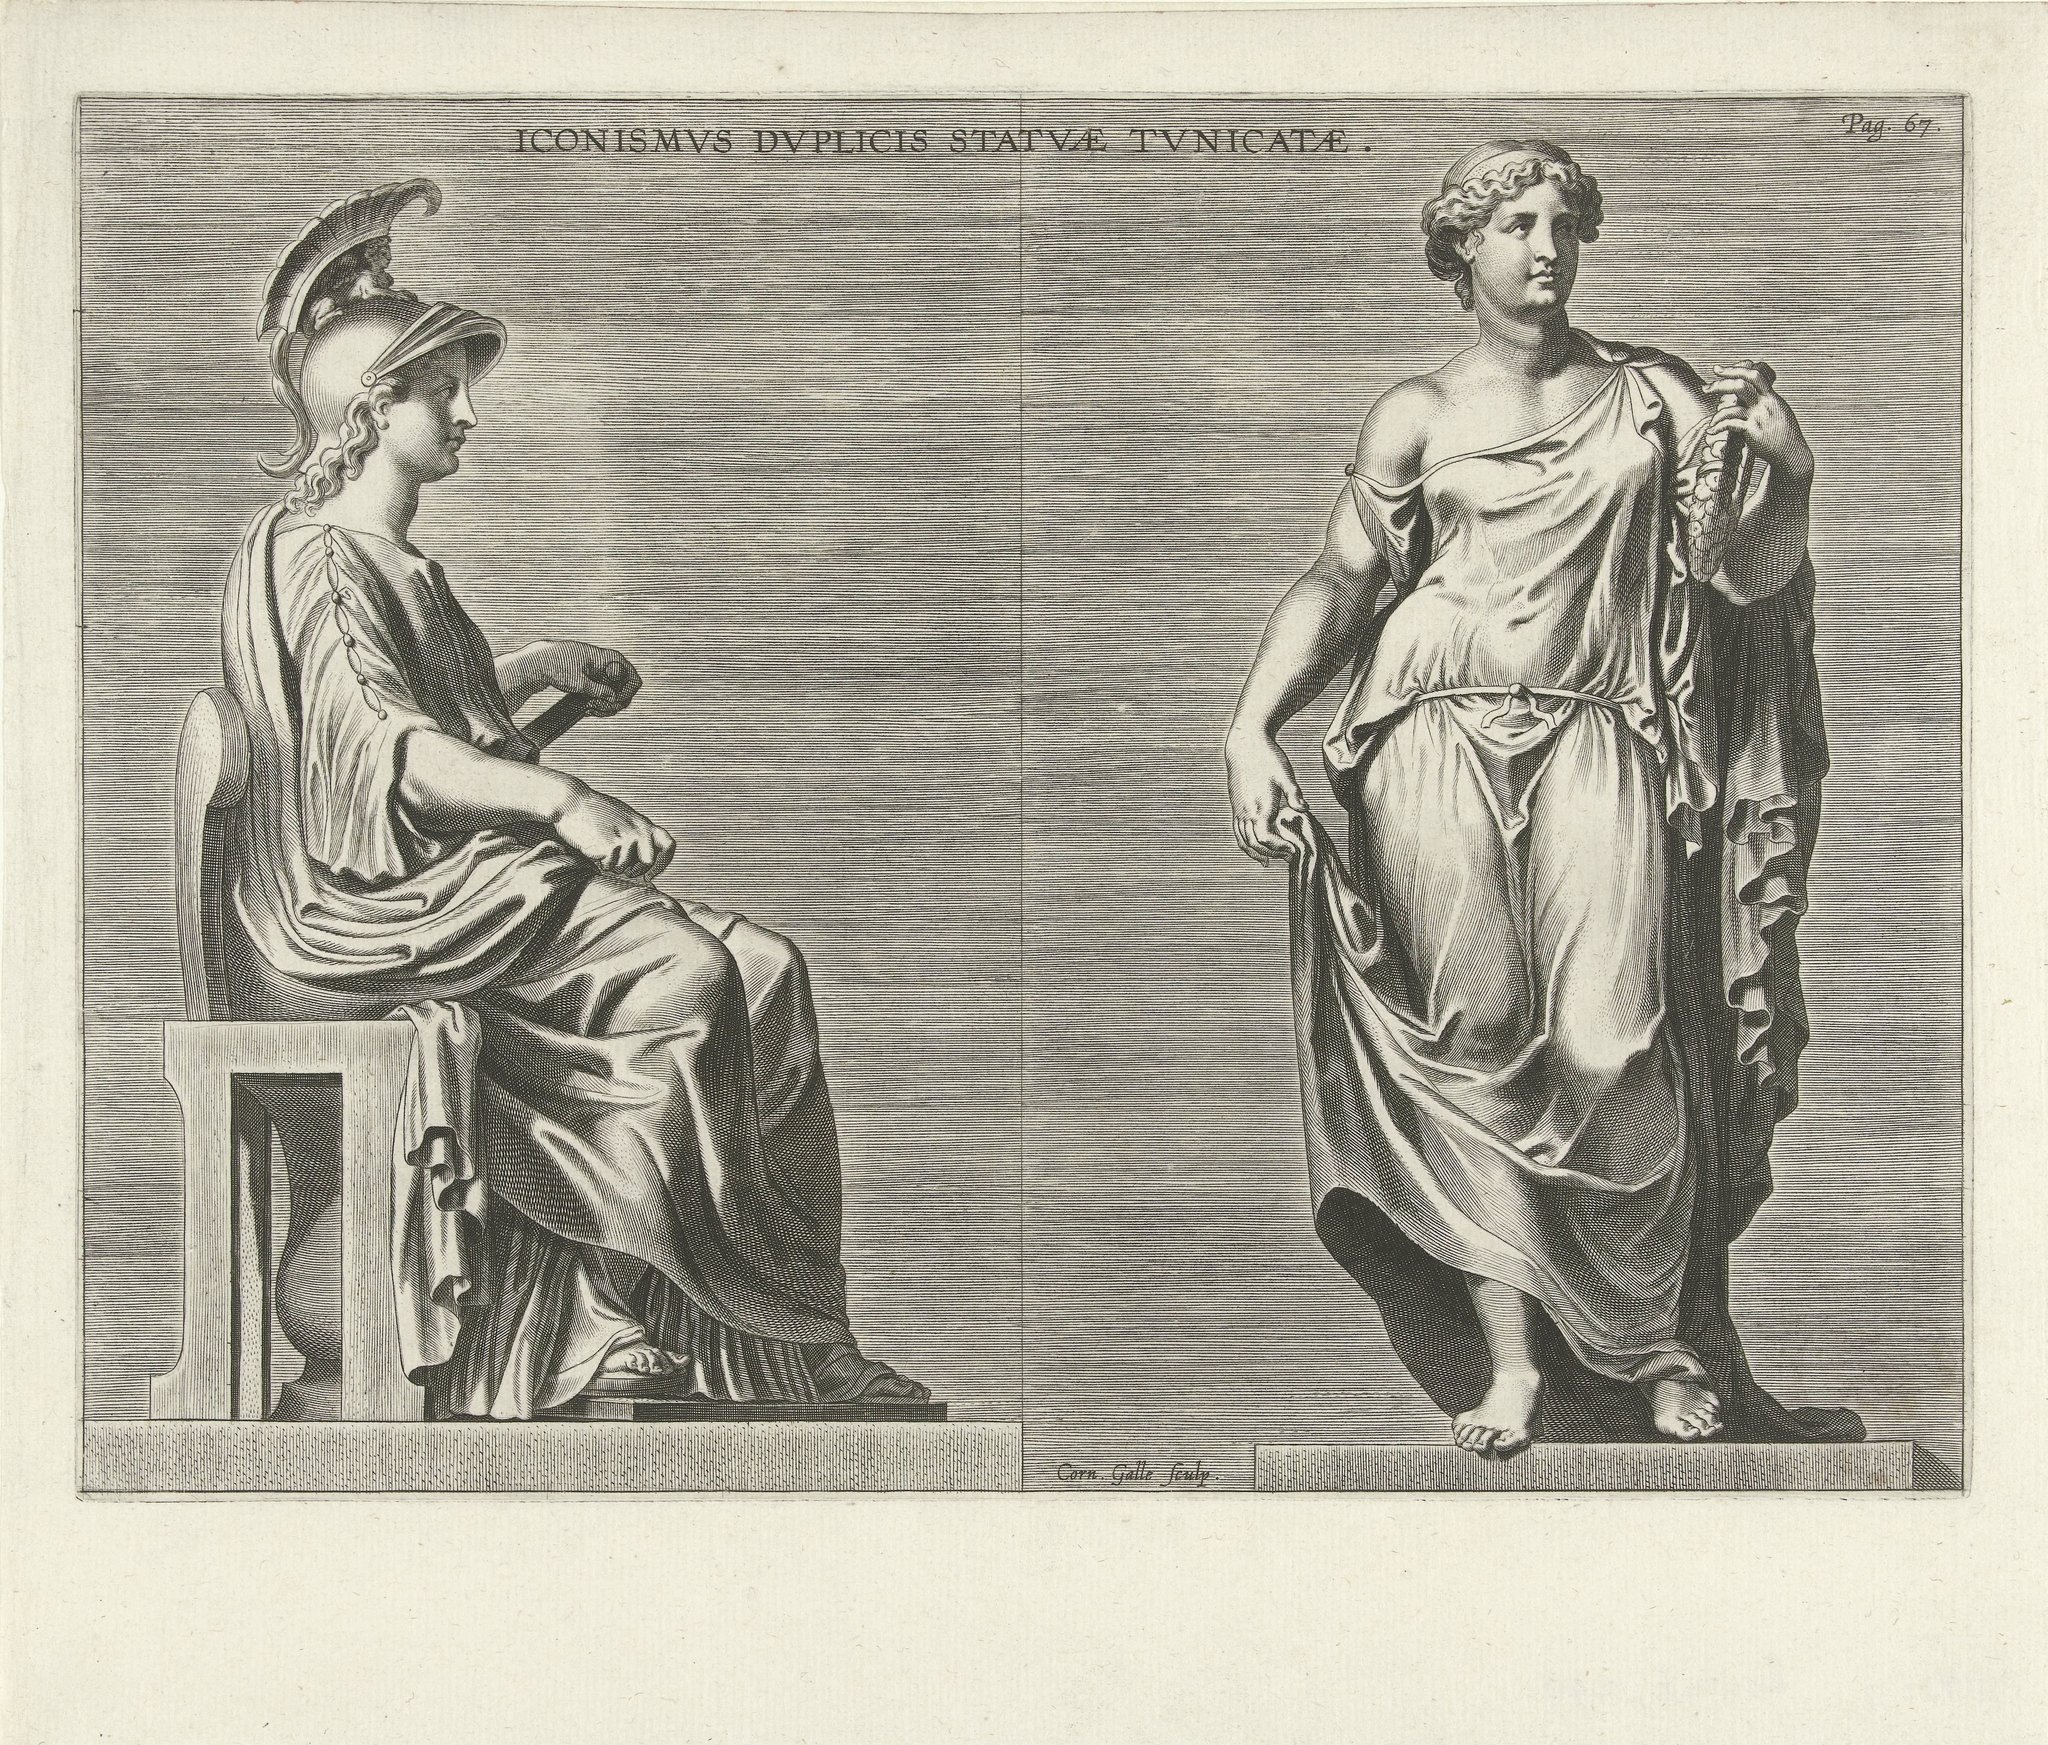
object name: book illustration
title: Iconismvs dvplicis statvae tvnicatae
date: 1608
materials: paper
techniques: engraving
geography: antwerp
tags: piece of sculpture, reproduction of a piece of sculpture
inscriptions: collector's mark: Lugt 240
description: Links een zijaanzicht van de zittende personificatie van de stad Rome: Roma, met helm en zwaard. Rechts een staande godin met bloemenkrans in haar hand. Het beeld is bekend onder de naam Flora Farnese. Illustratie voor een boek over de Romeinse cultuur.